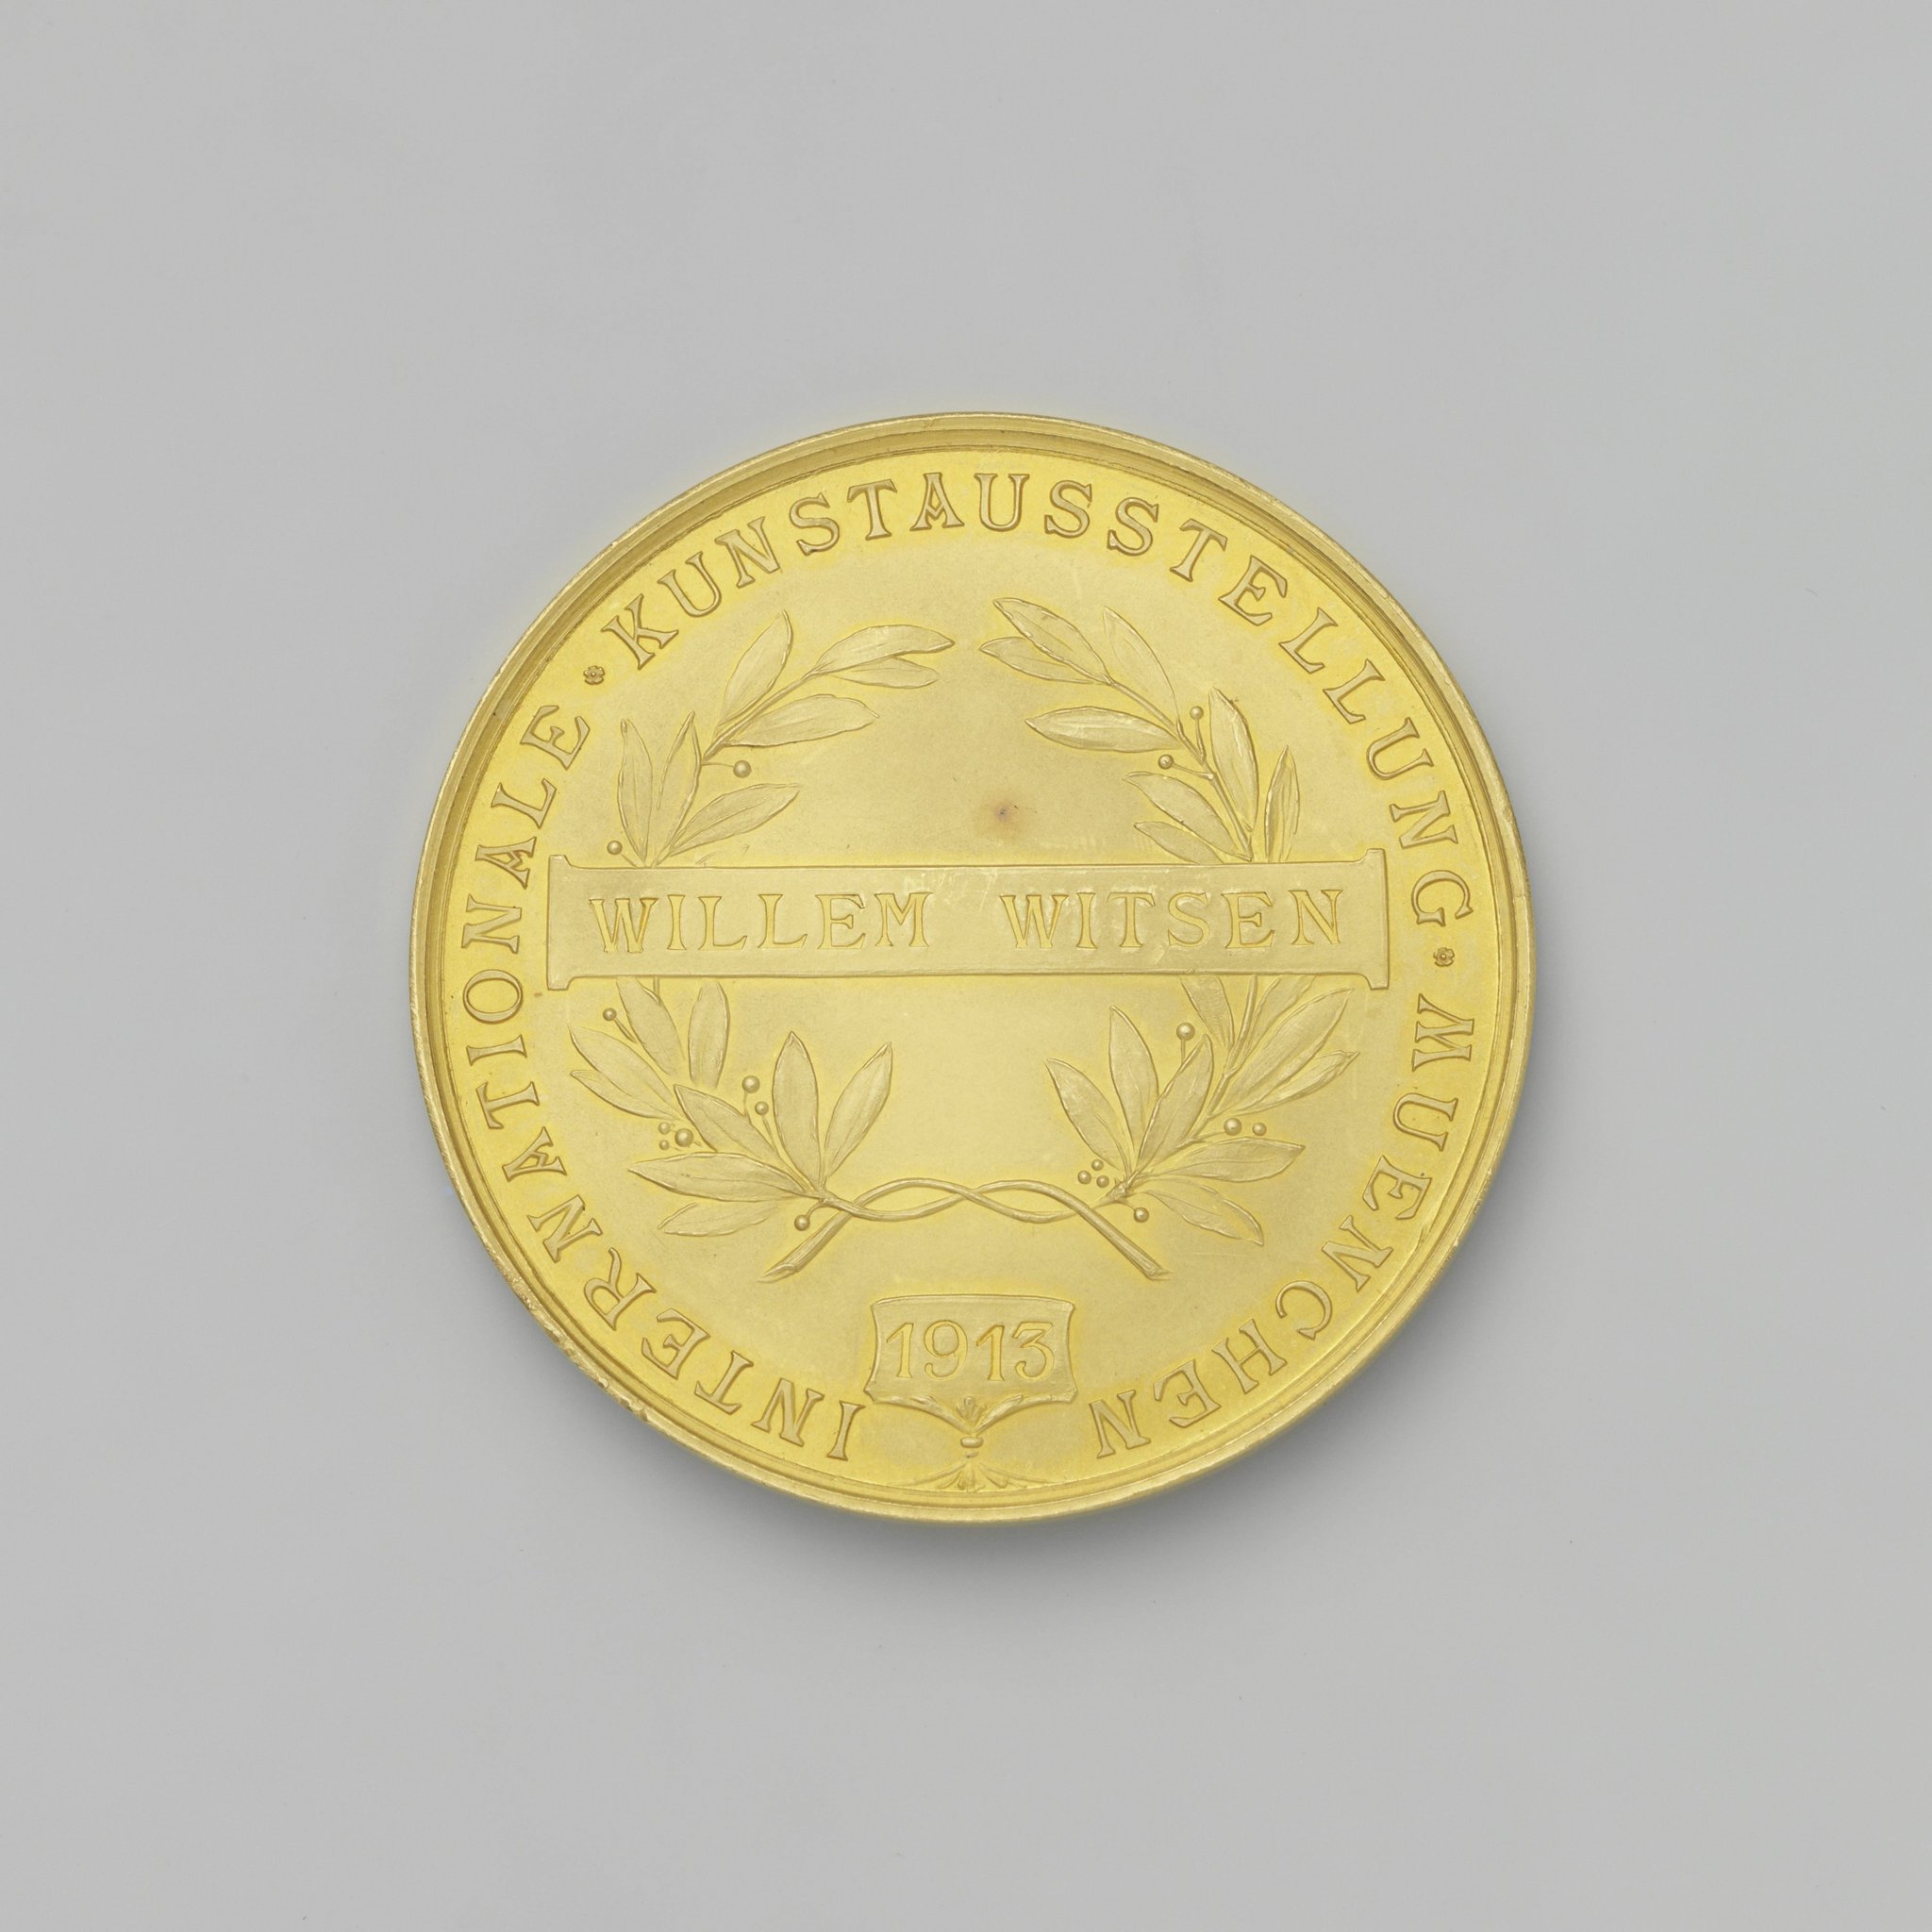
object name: medal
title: Medal Awarded by the International Exhibition of Art in Munich to Willem Witsen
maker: alois börsch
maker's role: sculptor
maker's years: 1855-1923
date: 1913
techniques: gilding, striking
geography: munich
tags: amsterdam, painter, draughtsman, willem witsen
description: Medals of honour. Medals of honour were awarded to individuals for noteworthy achievements.